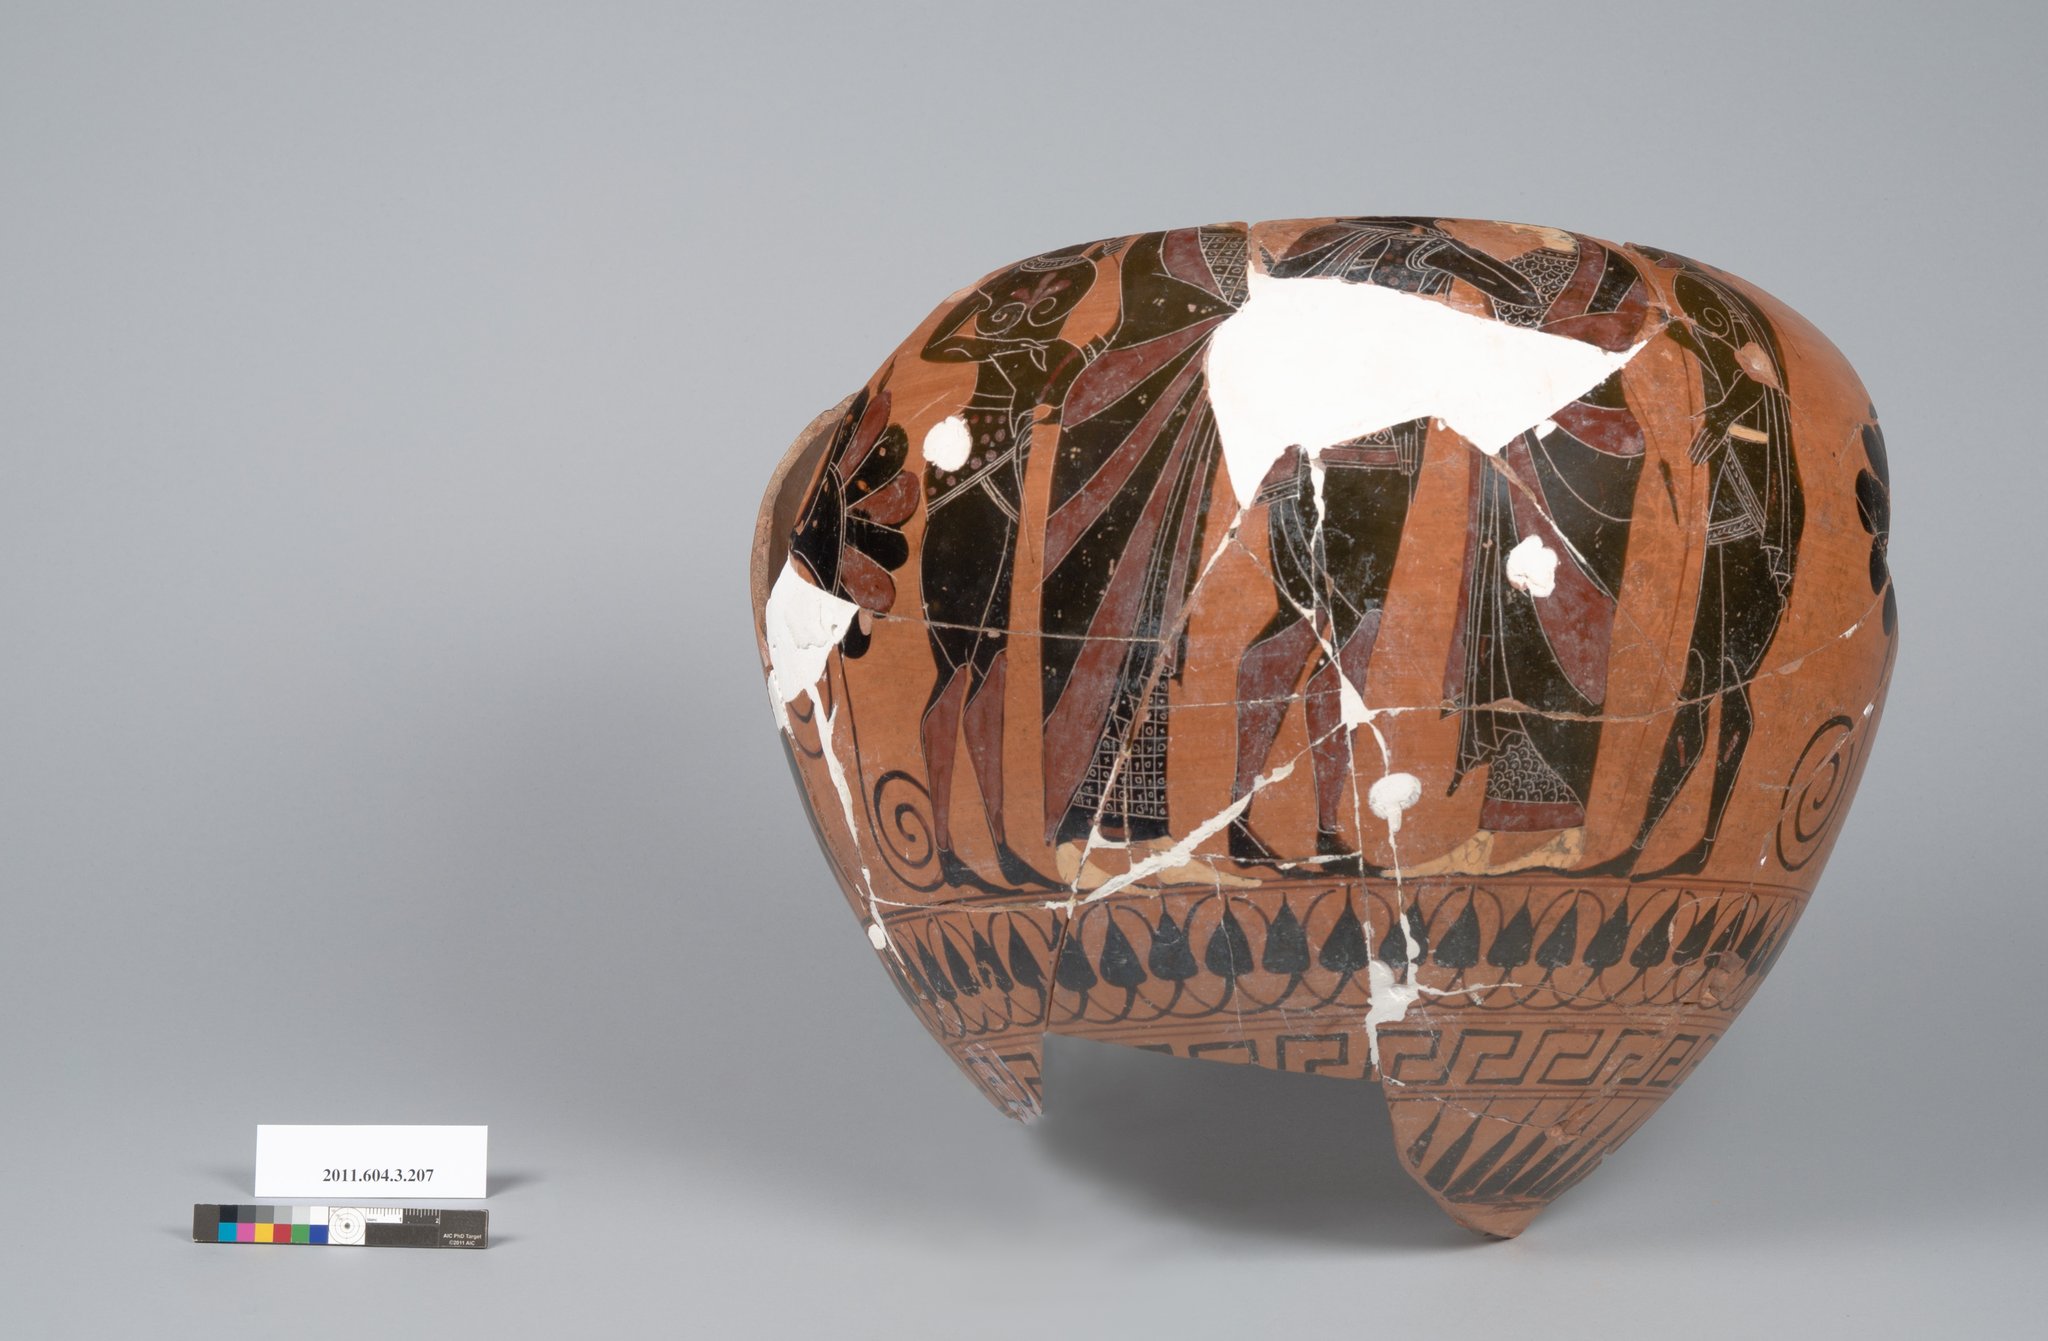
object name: neck amphora fragment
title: Terracotta fragment of neck-amphora (jar)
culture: greek, attic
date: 550-526 BCE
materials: terracotta